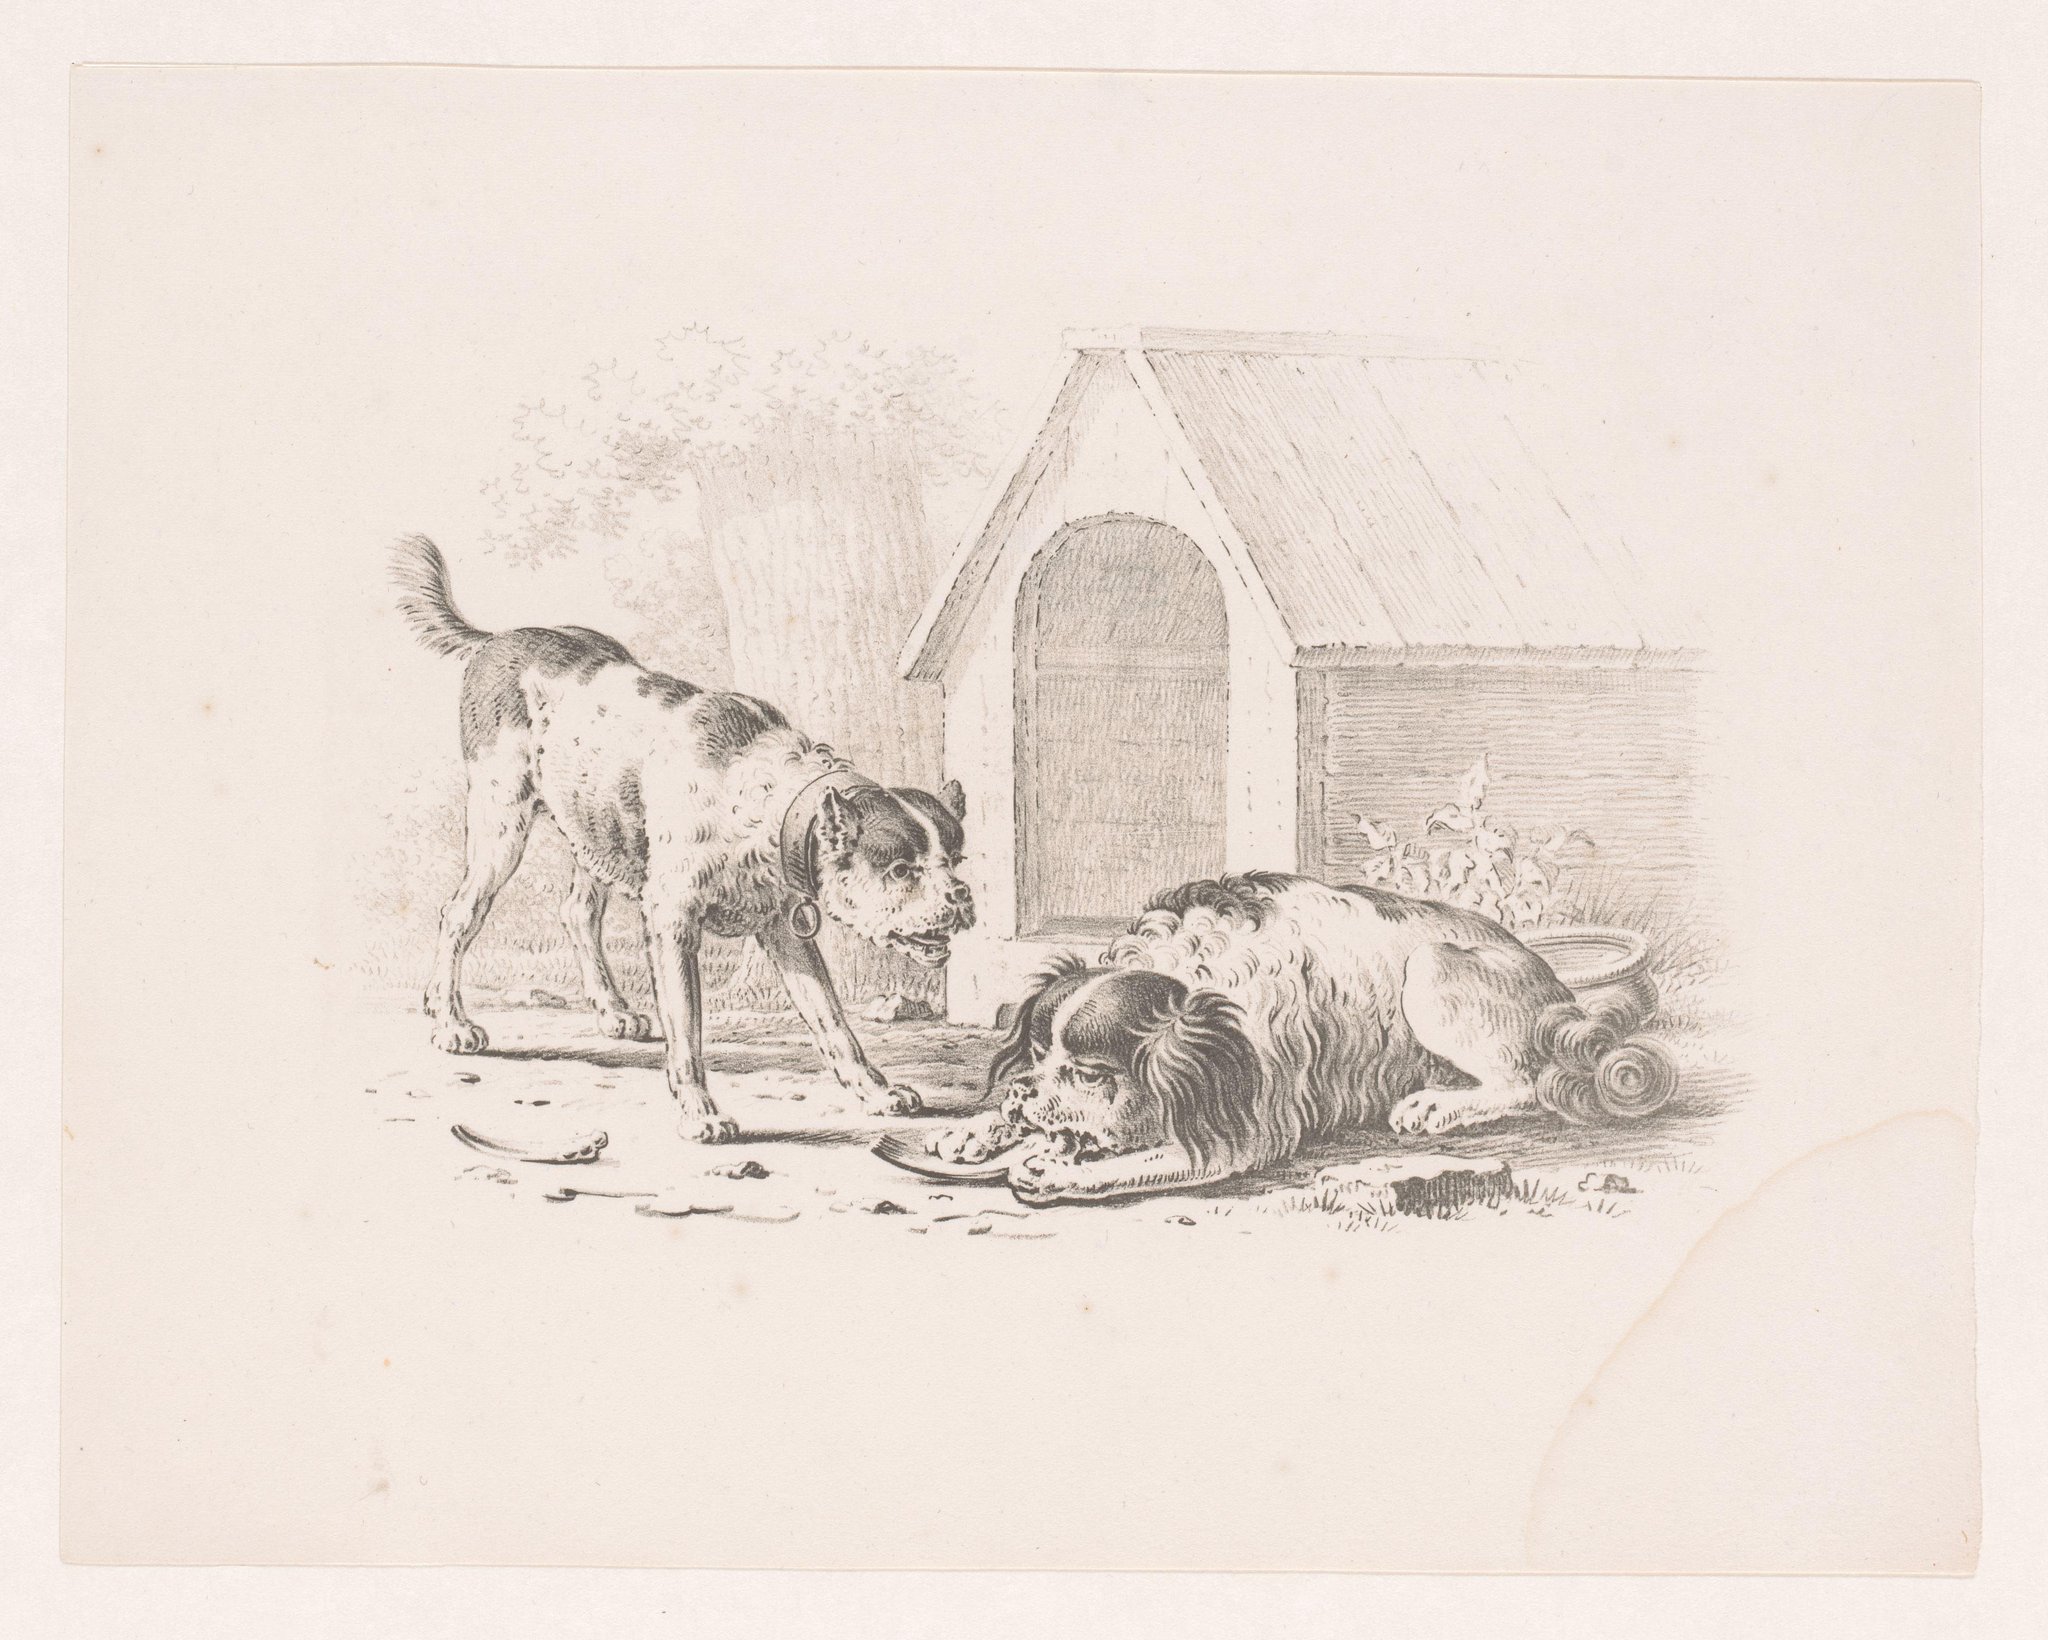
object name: print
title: Twee honden bij een hondenhok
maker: pieter de goeje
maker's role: draughtsman, print maker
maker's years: 1789-1859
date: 1809-1859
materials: paper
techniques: lithograph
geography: netherlands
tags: dog, dog (+ stable, shed, kennel)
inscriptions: collector's mark: Lugt 2228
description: Een hond kluift aan een bot, de tweede hond staat ernaast.